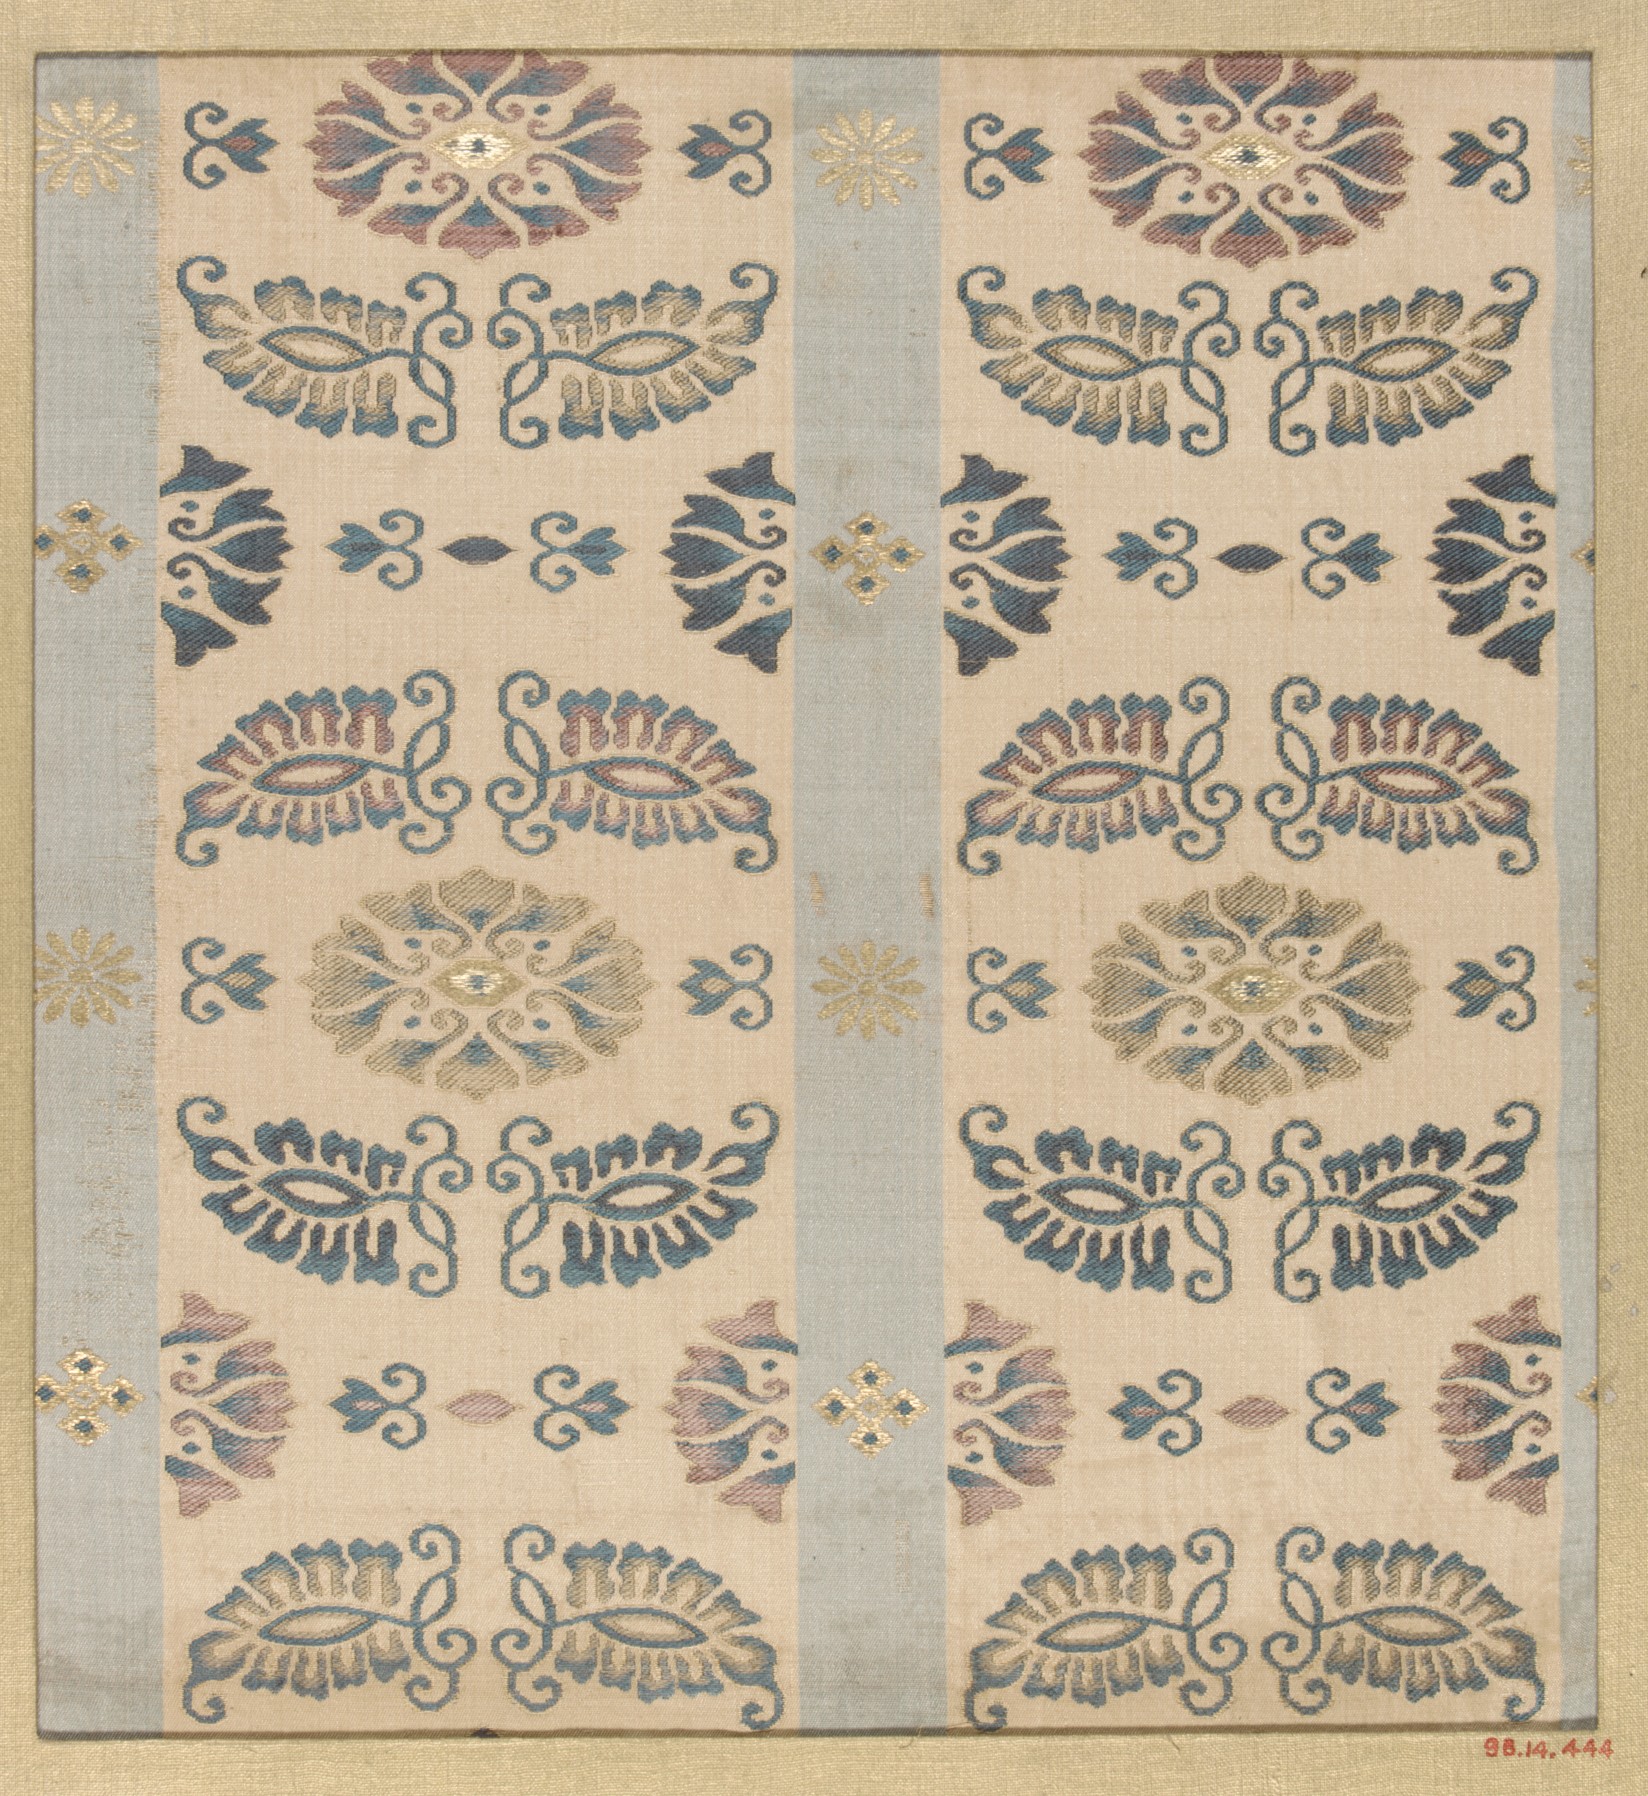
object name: piece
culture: japanese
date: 1701-1900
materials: silk